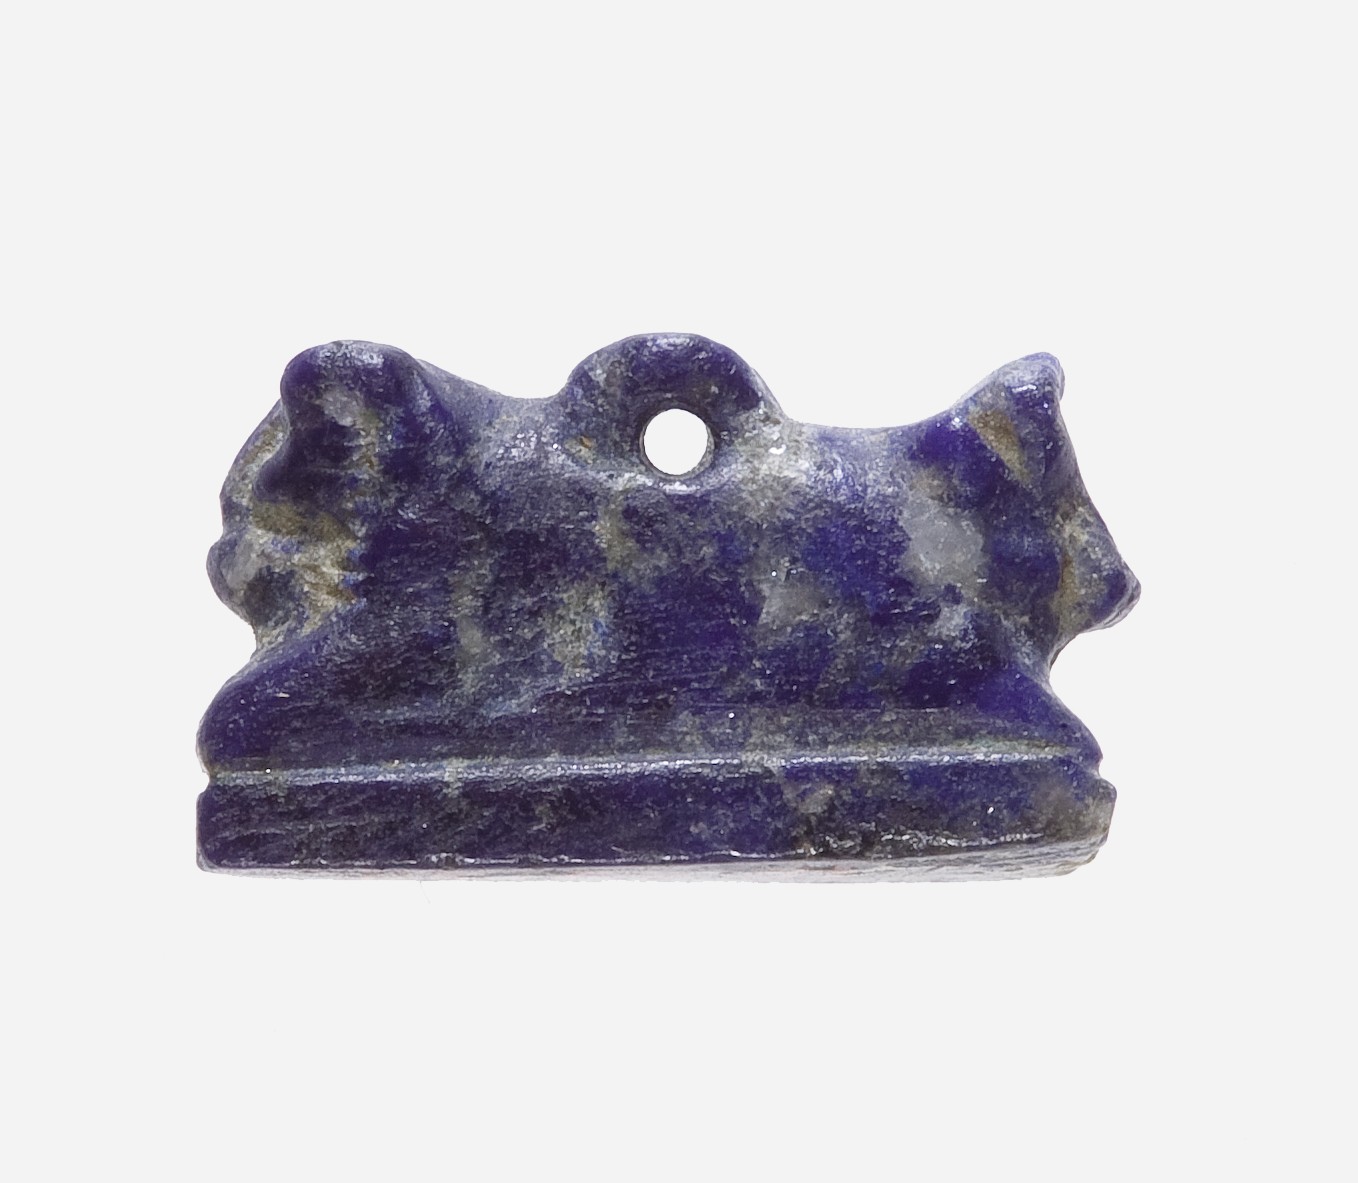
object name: amulet, lion back to back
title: Amulet: lion and bull back to back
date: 522-343 BCE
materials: lapis lazuli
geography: egypt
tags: lions